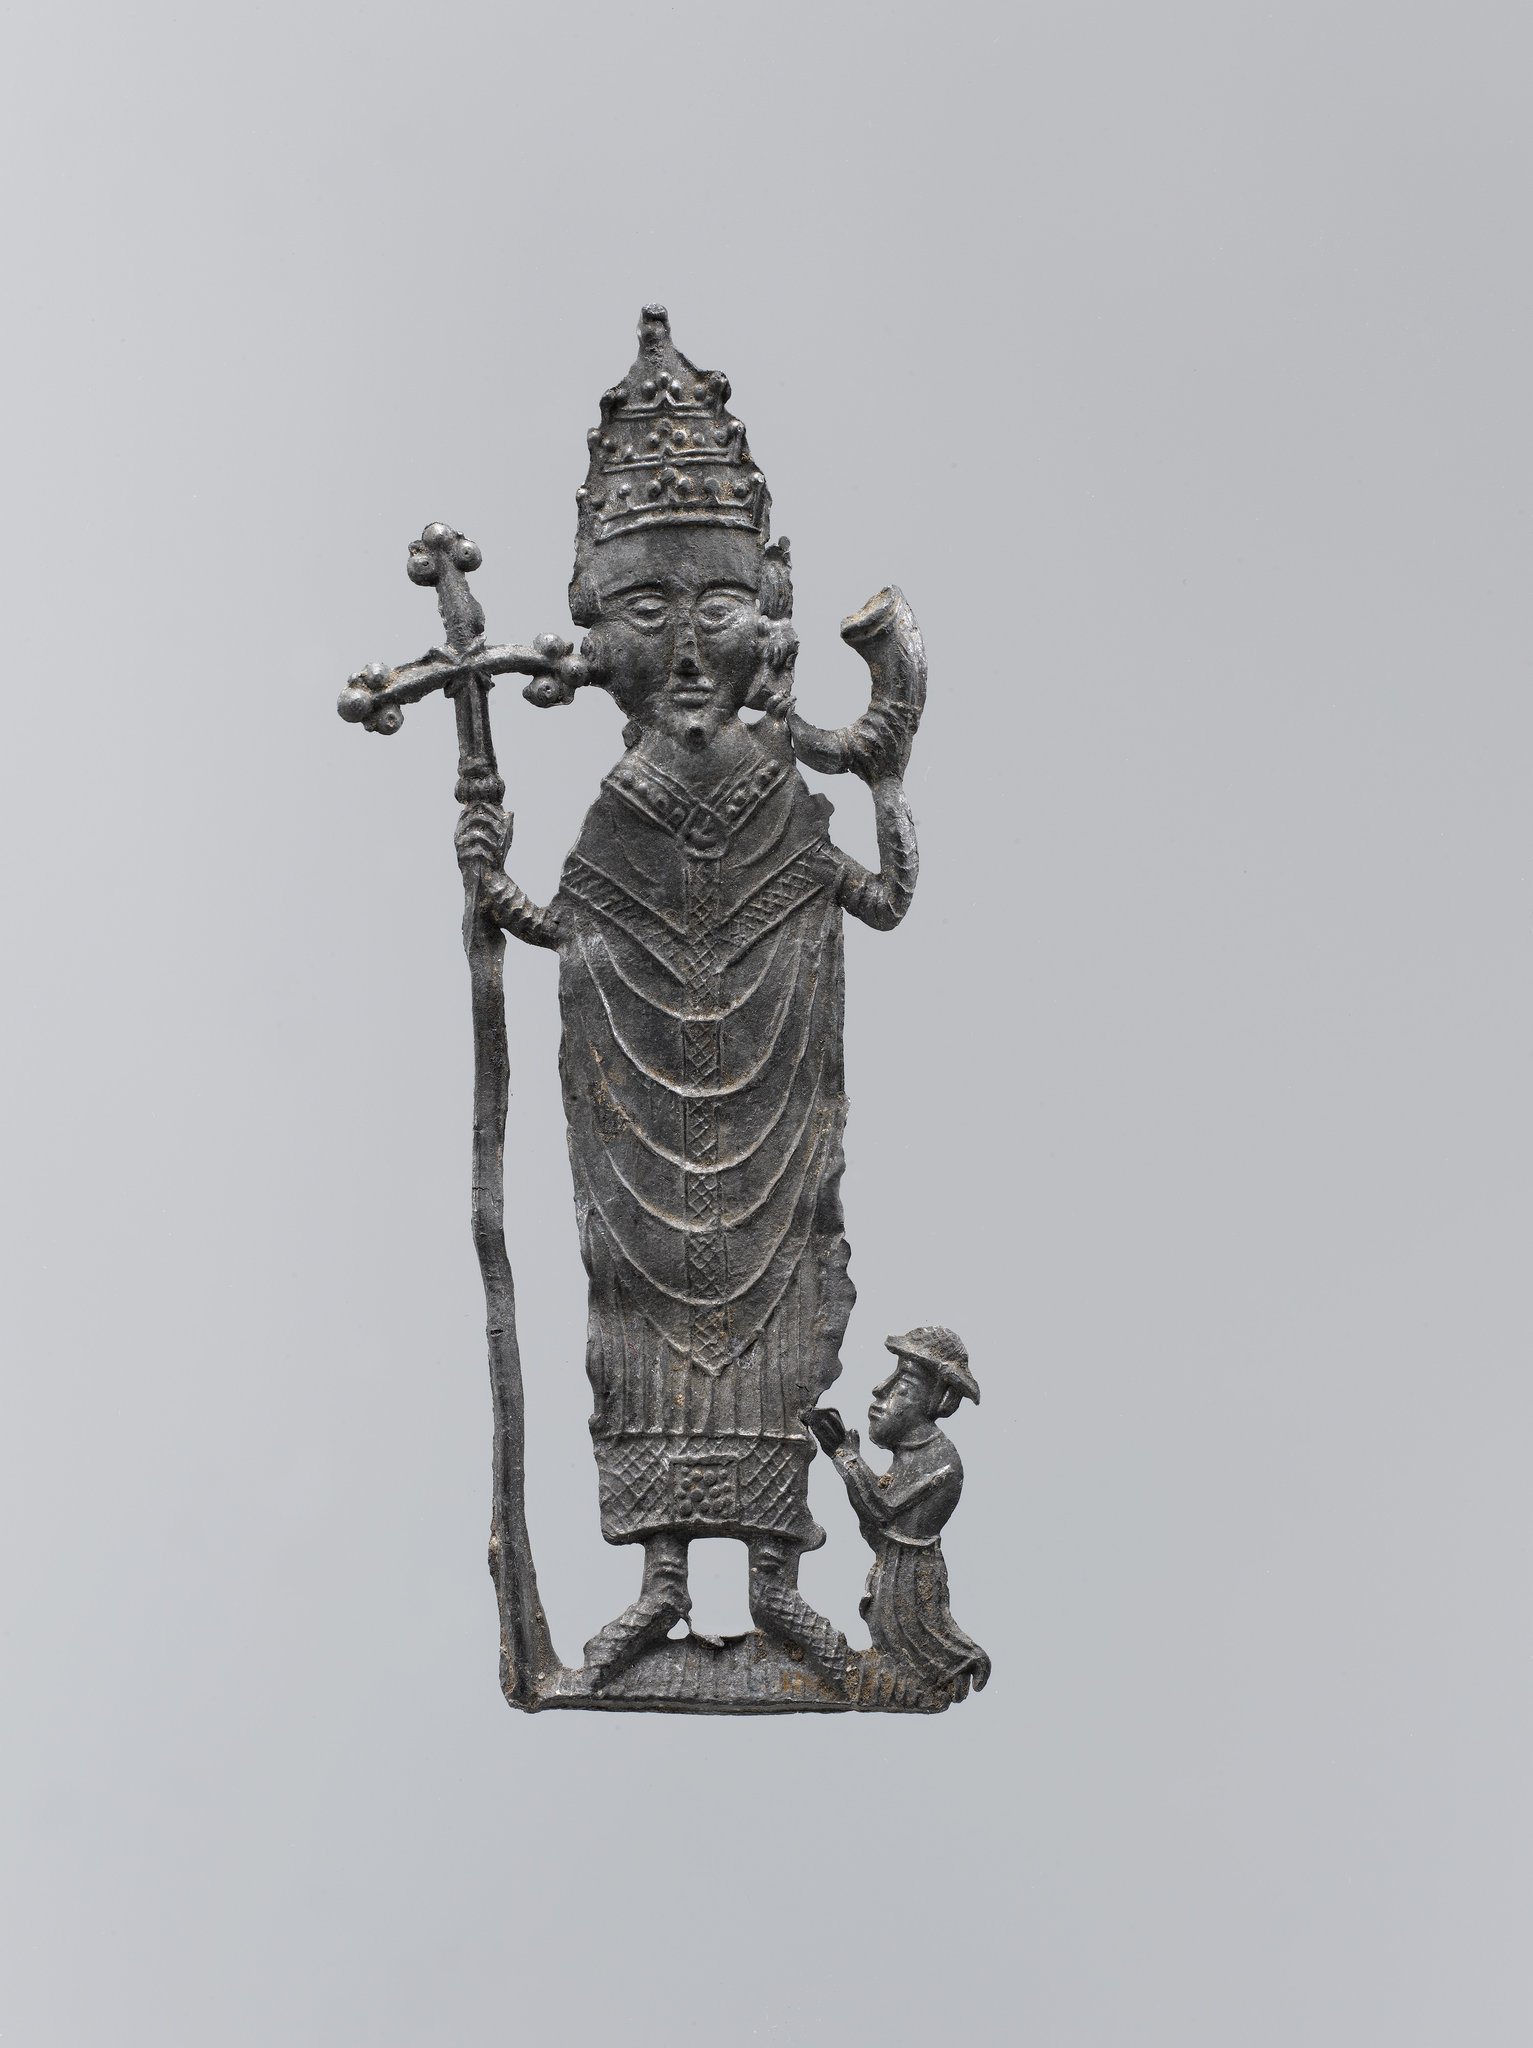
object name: pilgrim's badge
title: Pilgrim's Badge: Saint Cornelius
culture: south netherlandish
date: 1400-1450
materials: alloy, lead, tin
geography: probably ninove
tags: saints